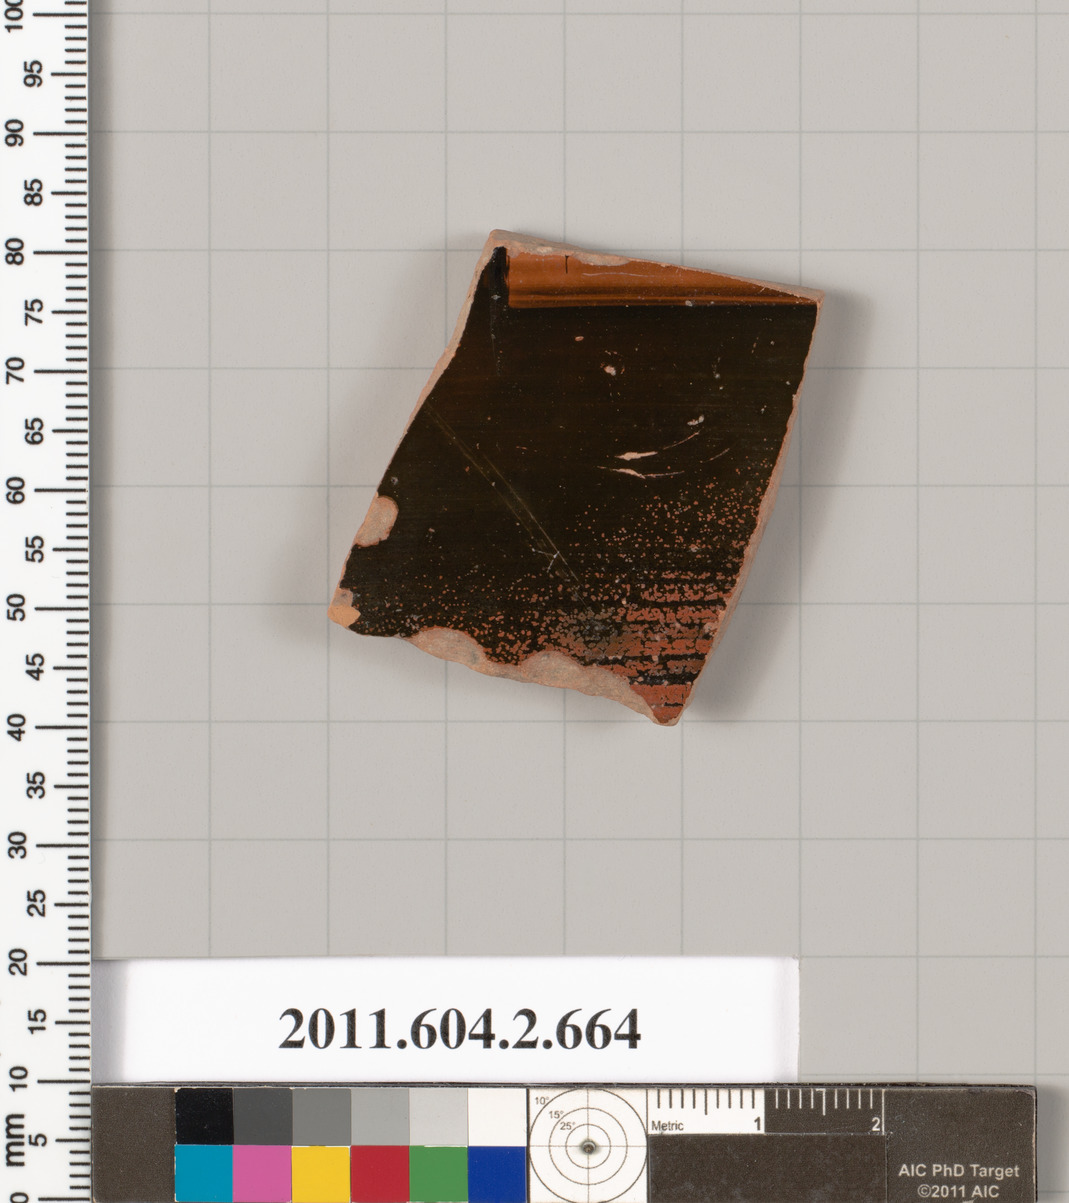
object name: column krater fragment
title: Terracotta fragment of a column-krater (bowl for mixing wine and water)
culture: greek, attic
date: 460-440 BCE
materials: terracotta